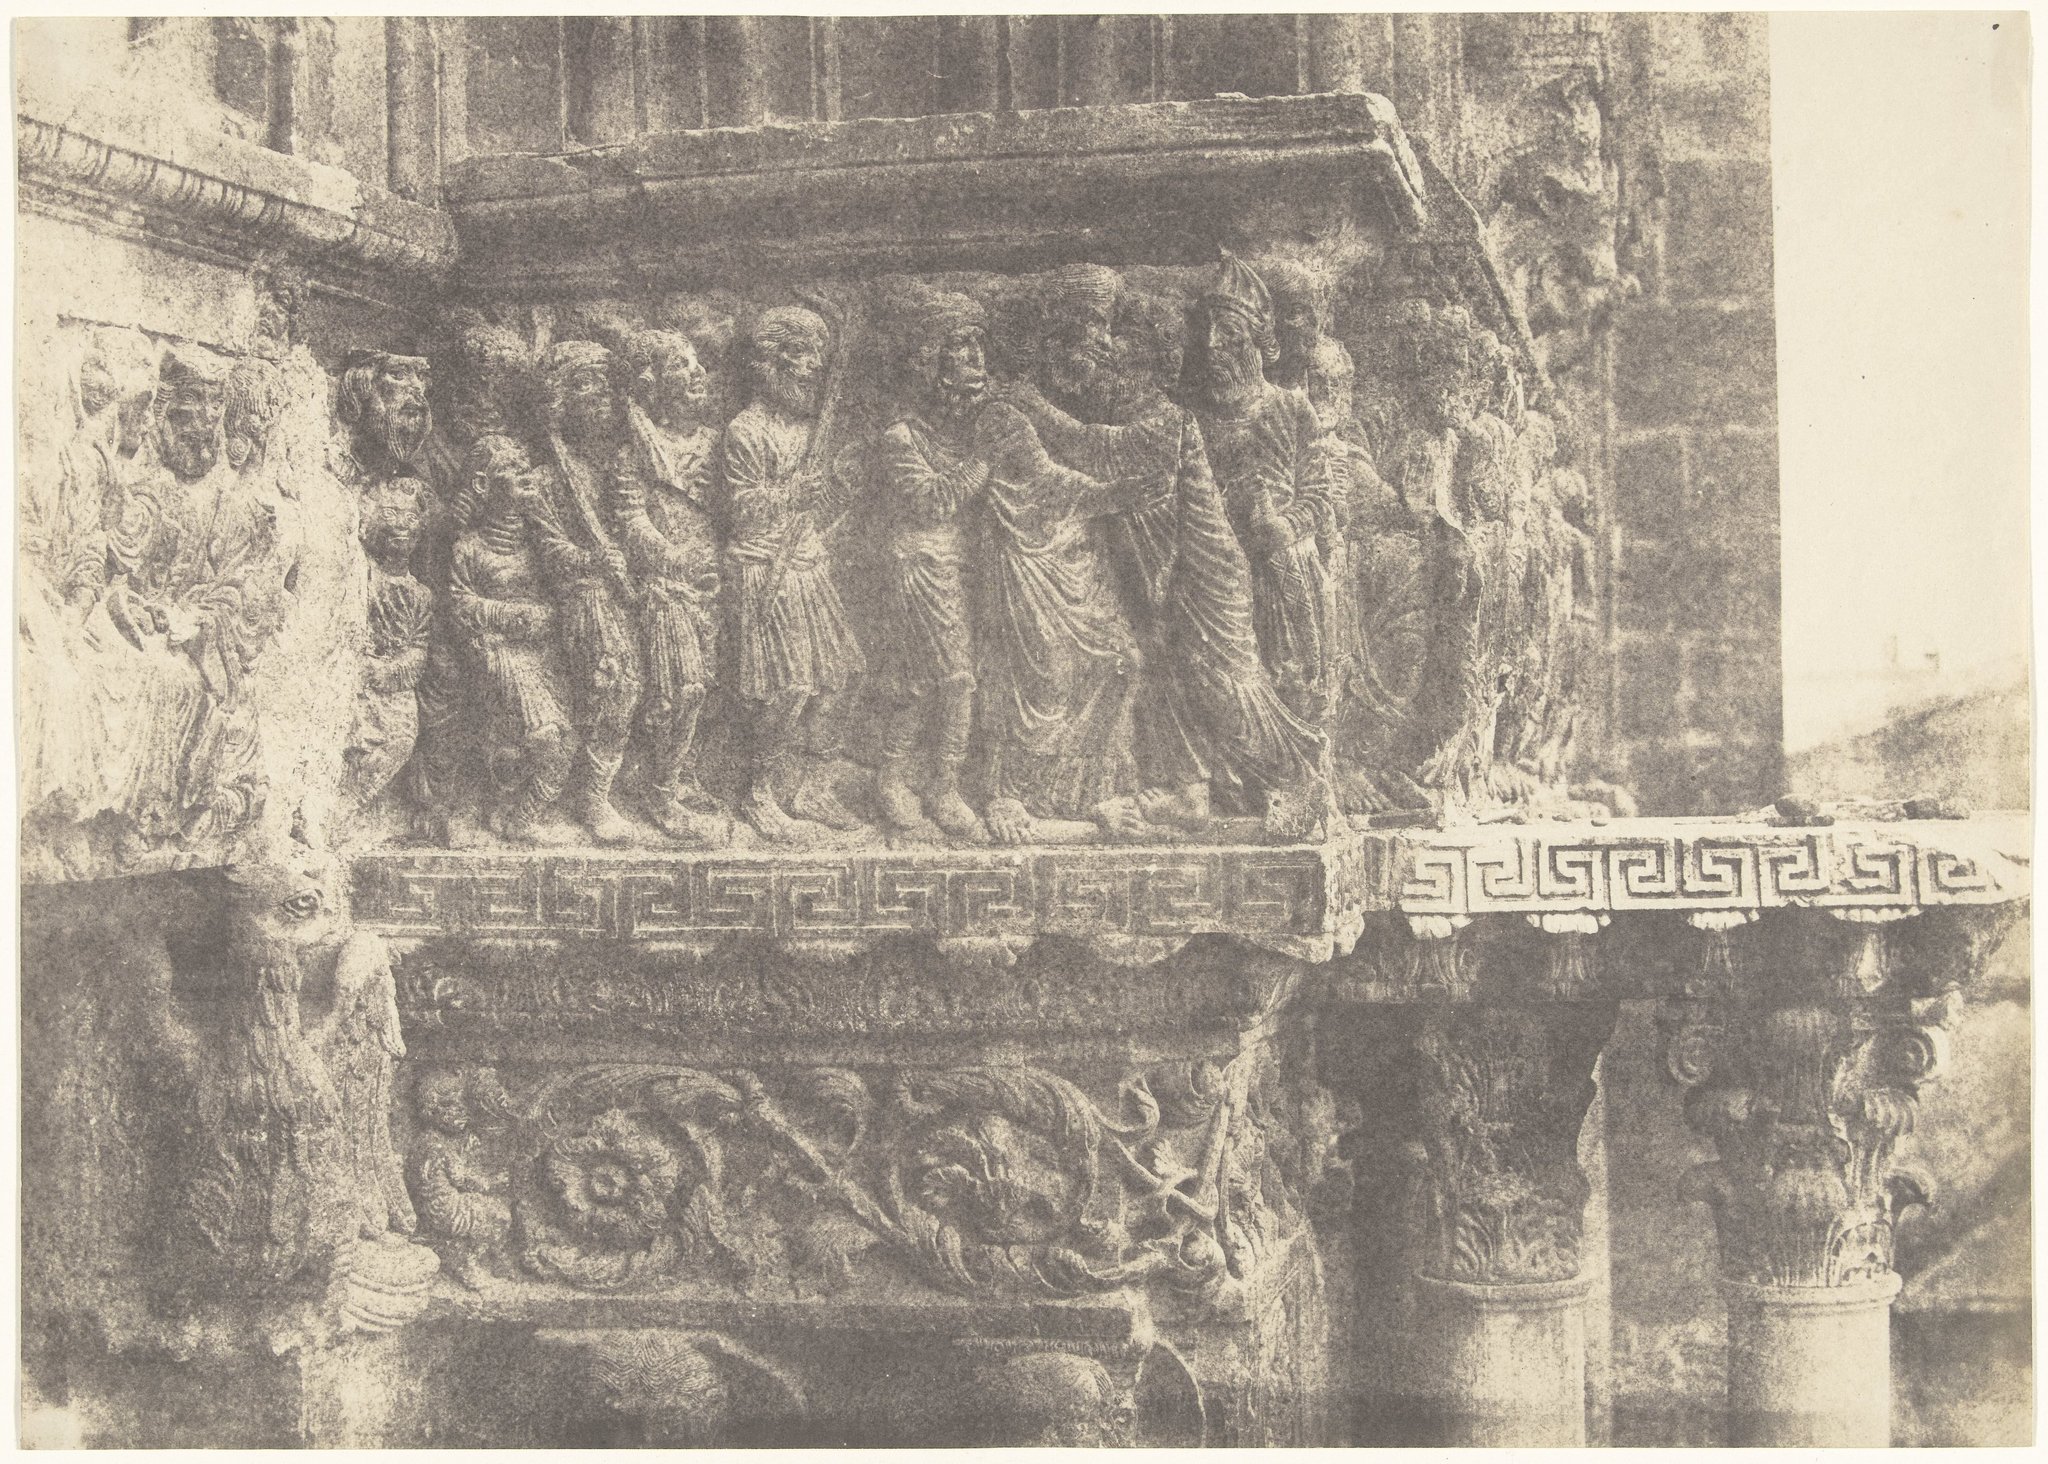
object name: photograph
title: Bas-reliëf aan de kerk van Saint-Gilles-du-Gard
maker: charles nègre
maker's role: fotograaf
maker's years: 1820-1880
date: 1852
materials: paper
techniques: salted paper print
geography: saint-gilles-du-gard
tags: sculpture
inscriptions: number: ‘203’